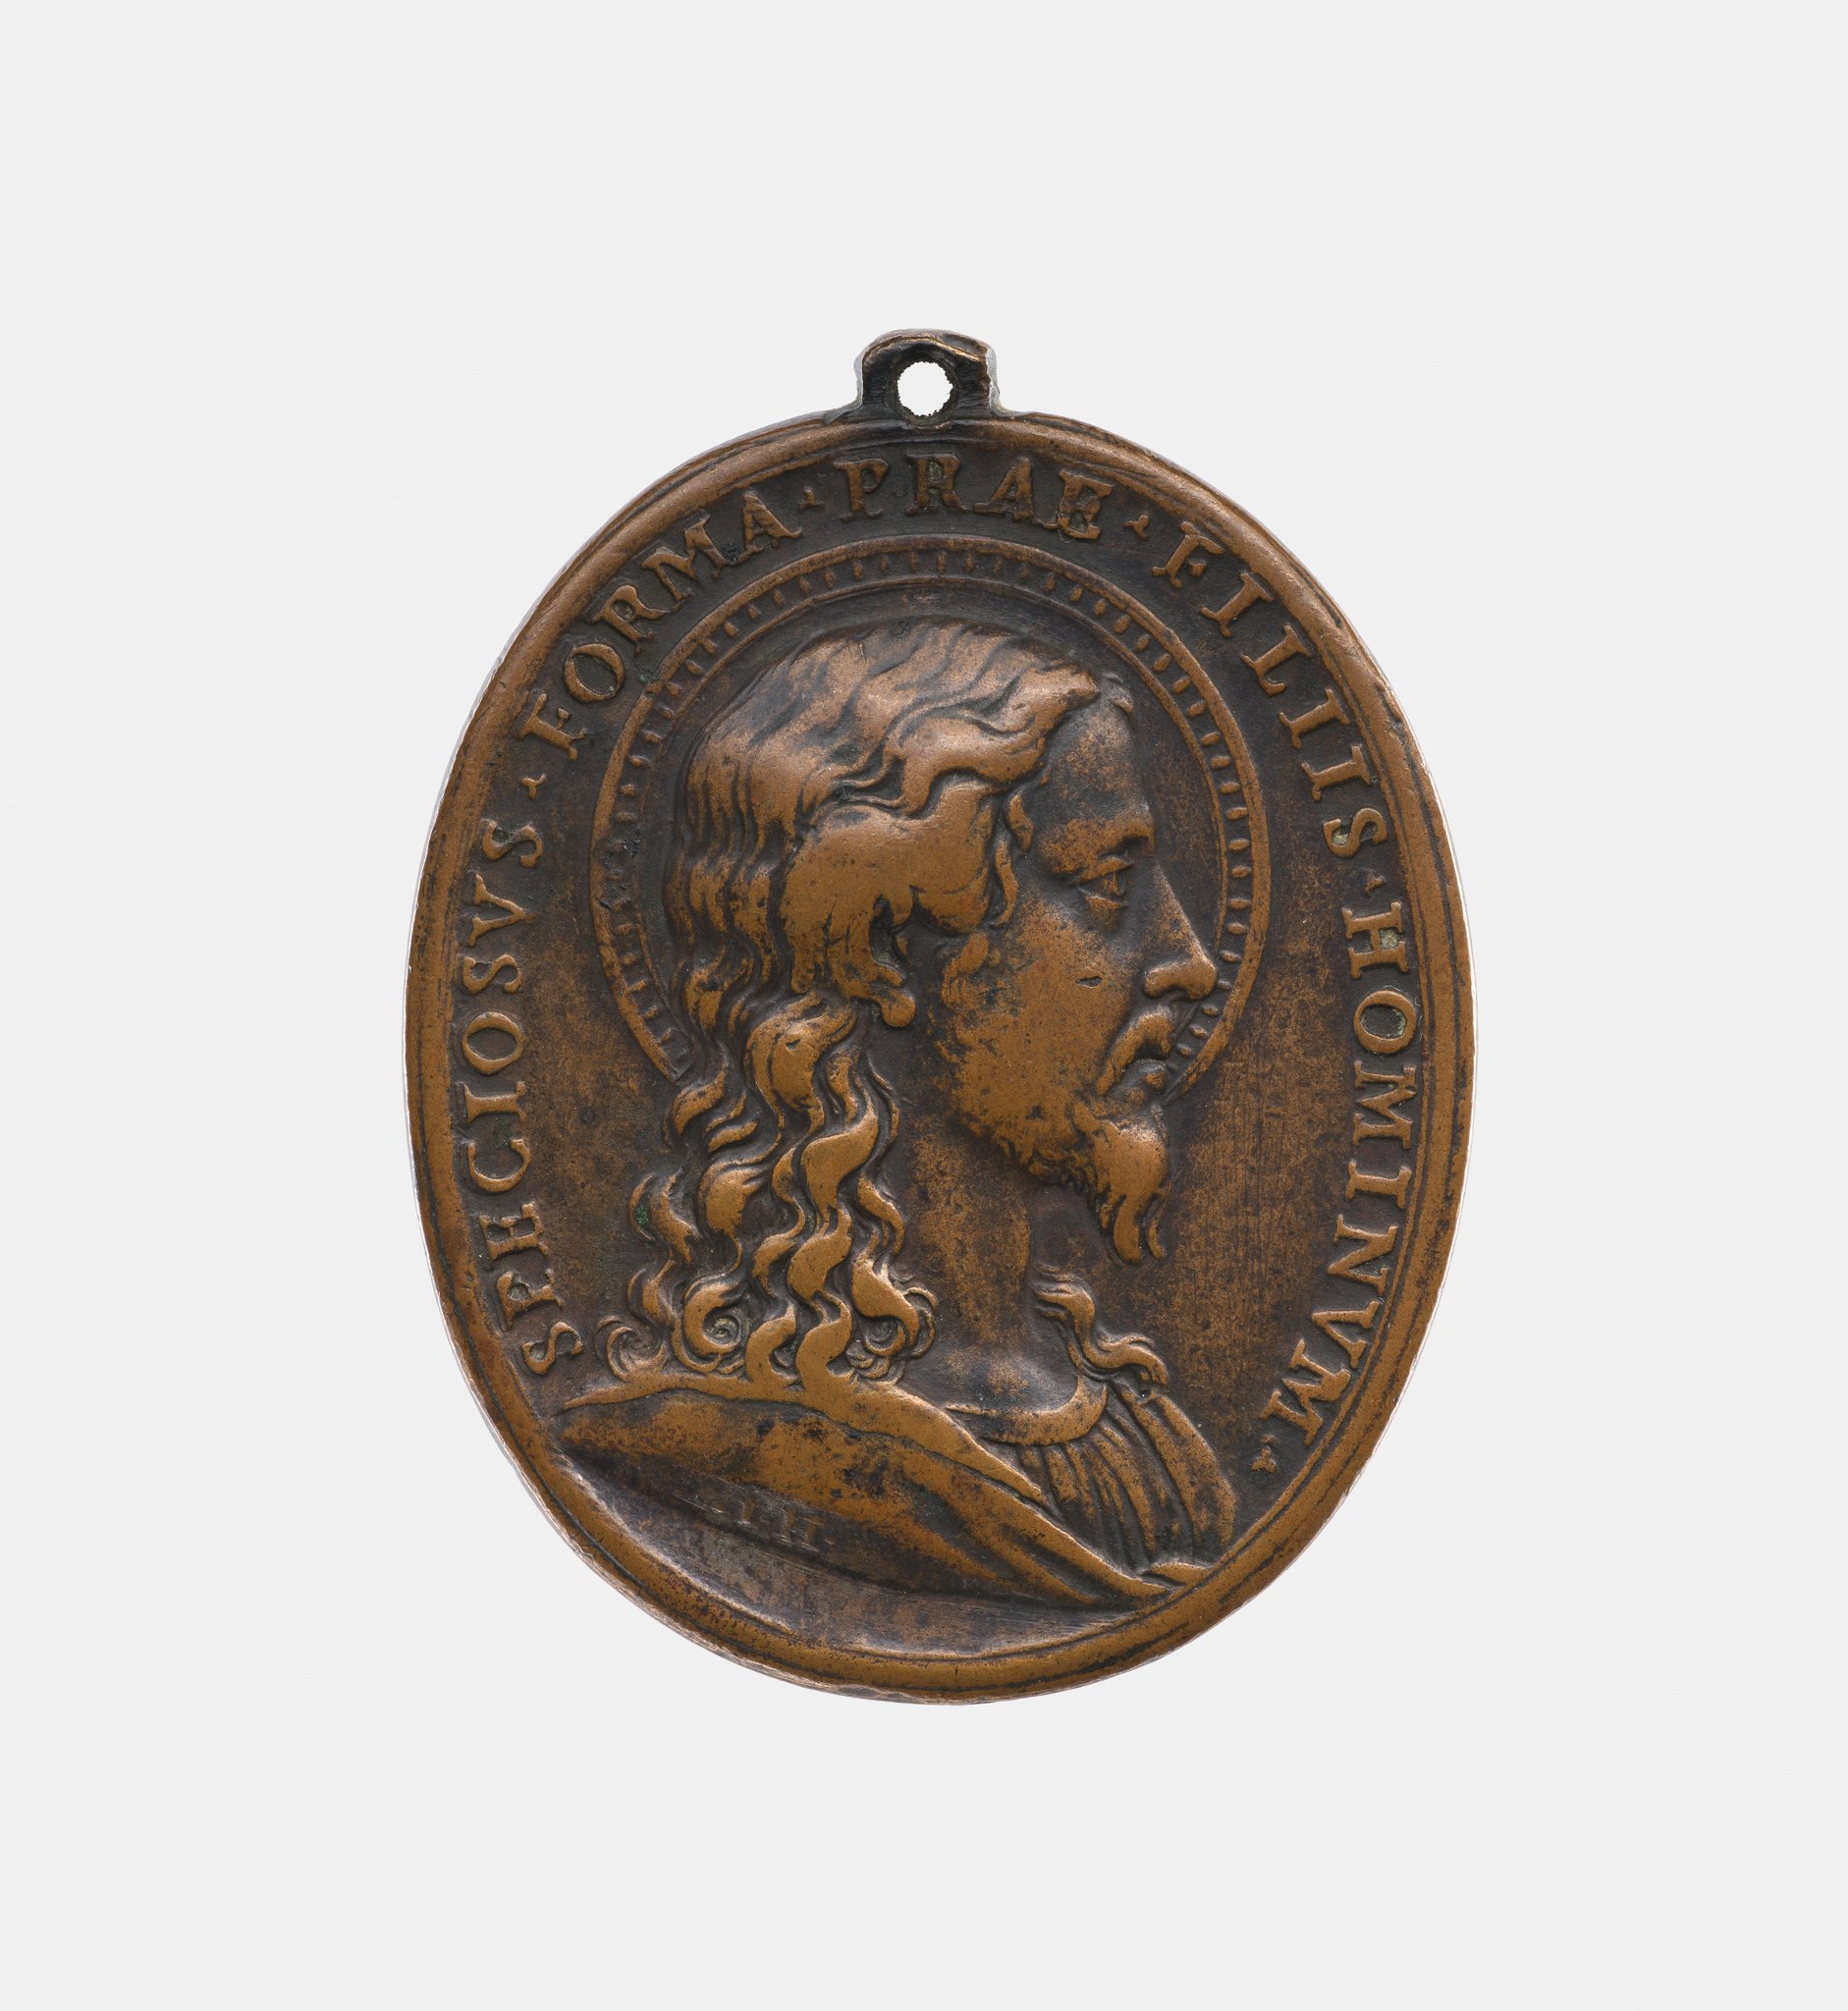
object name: medal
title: Christ / Mary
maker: giovanni martino hamerani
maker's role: artist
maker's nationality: italian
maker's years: 1646-1705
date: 1651-1700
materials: bronze